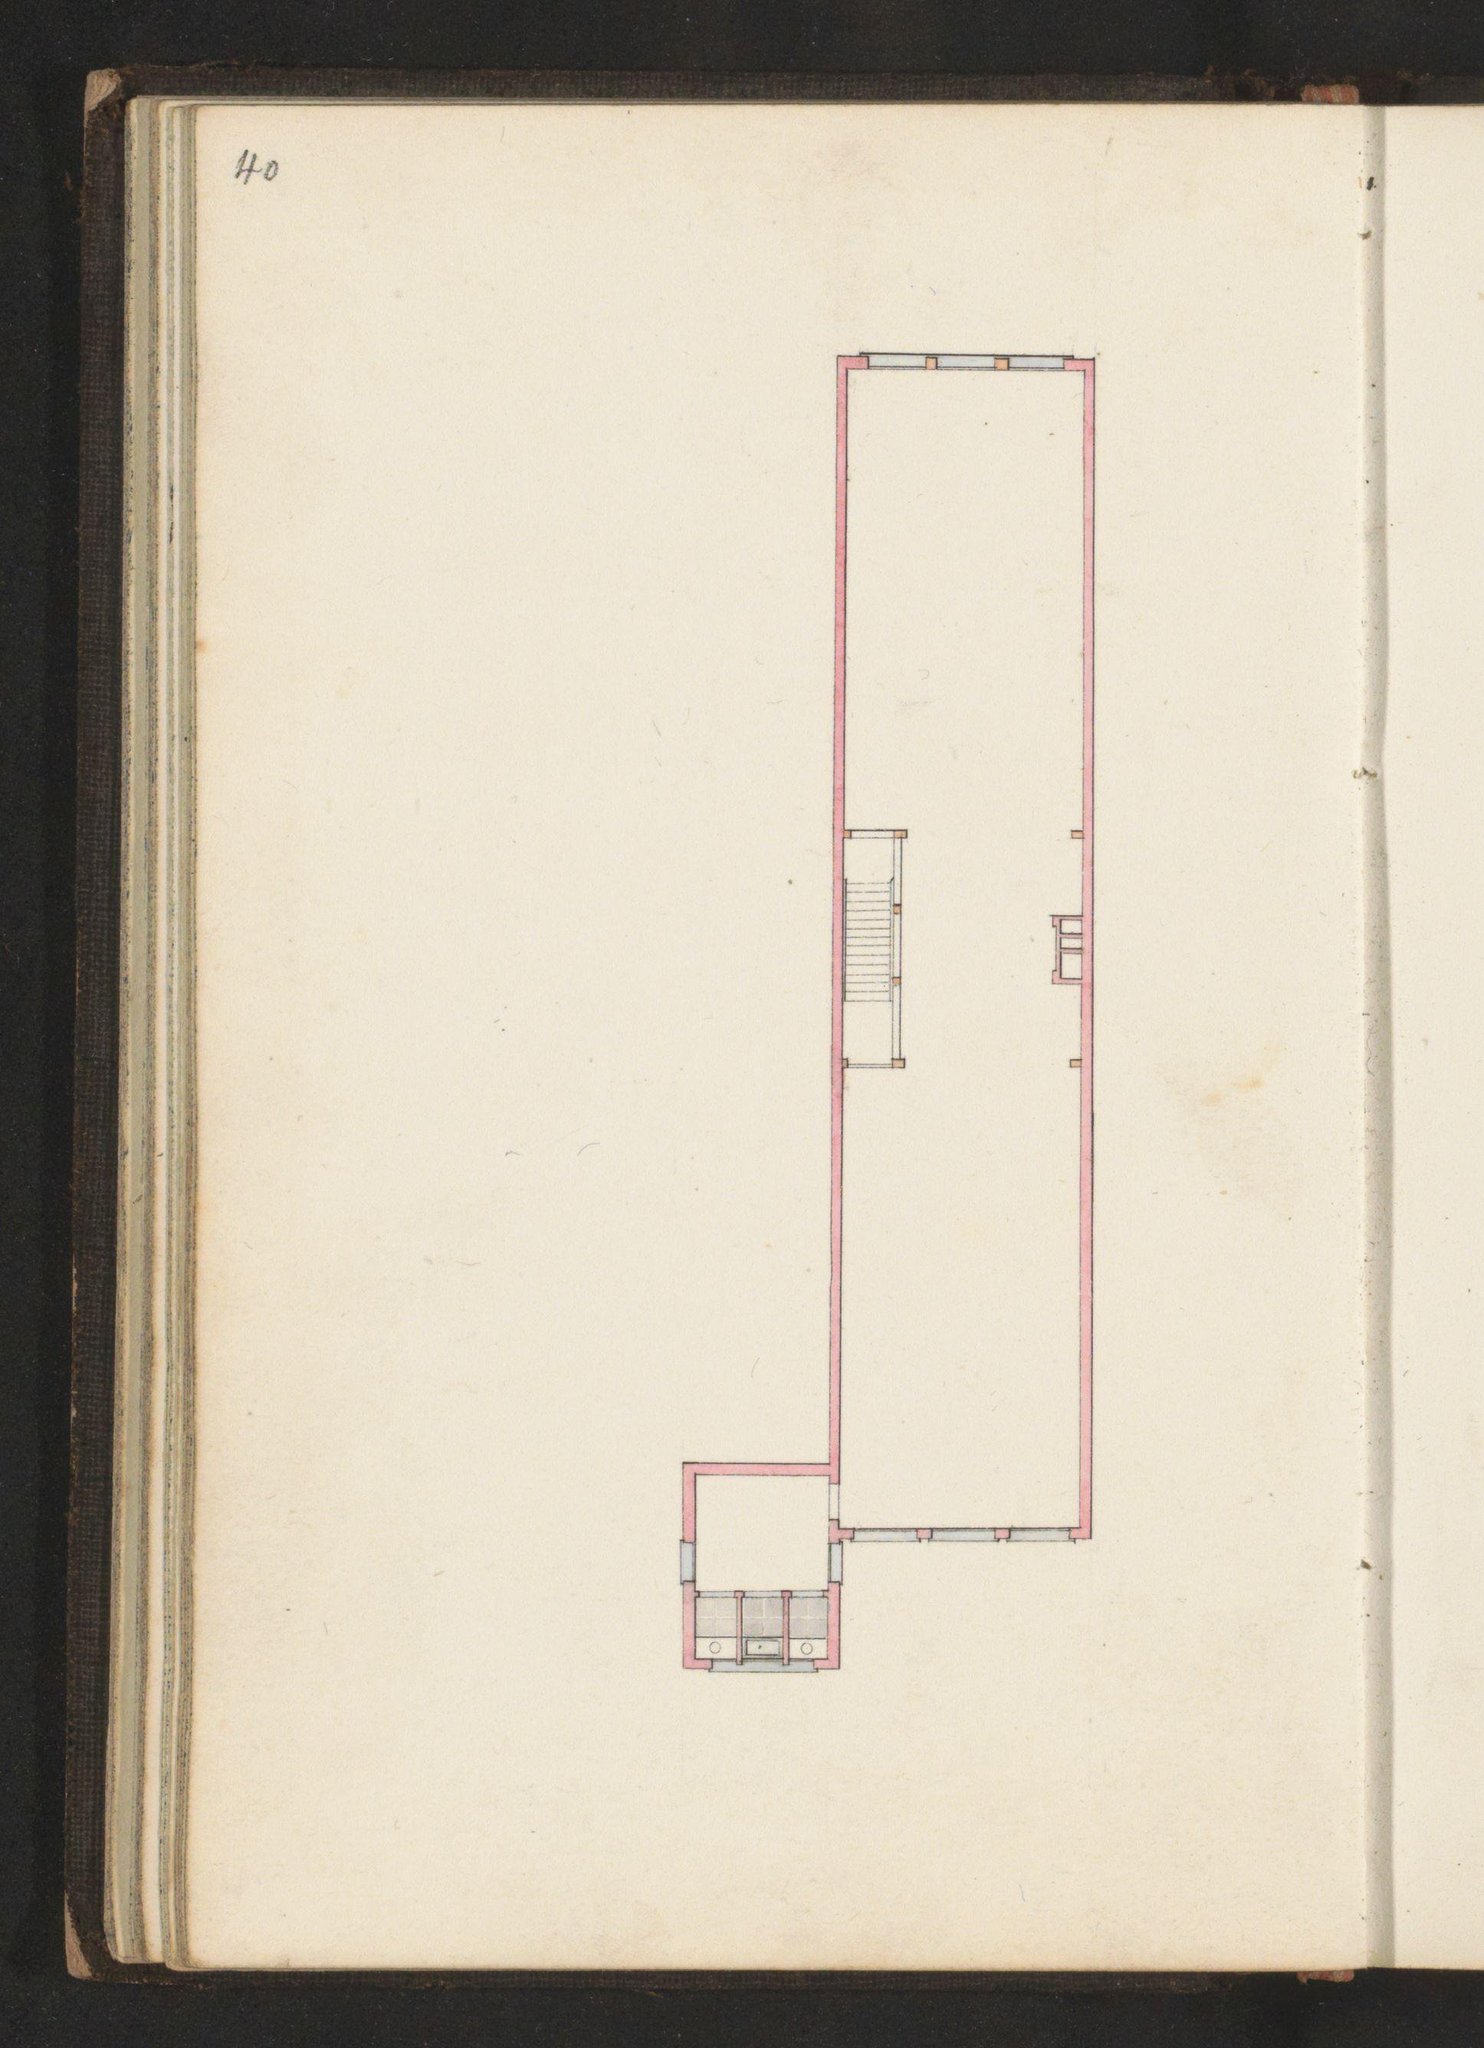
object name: sketchbook leaf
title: Plattegrond van een verdieping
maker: willem springer jr.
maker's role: draughtsman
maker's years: 1815-1907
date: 1864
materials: ink, paper, watercolor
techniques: brush, pen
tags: plan ~ architecture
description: Pagina 40 uit een schetsboek met 164 pagina's.